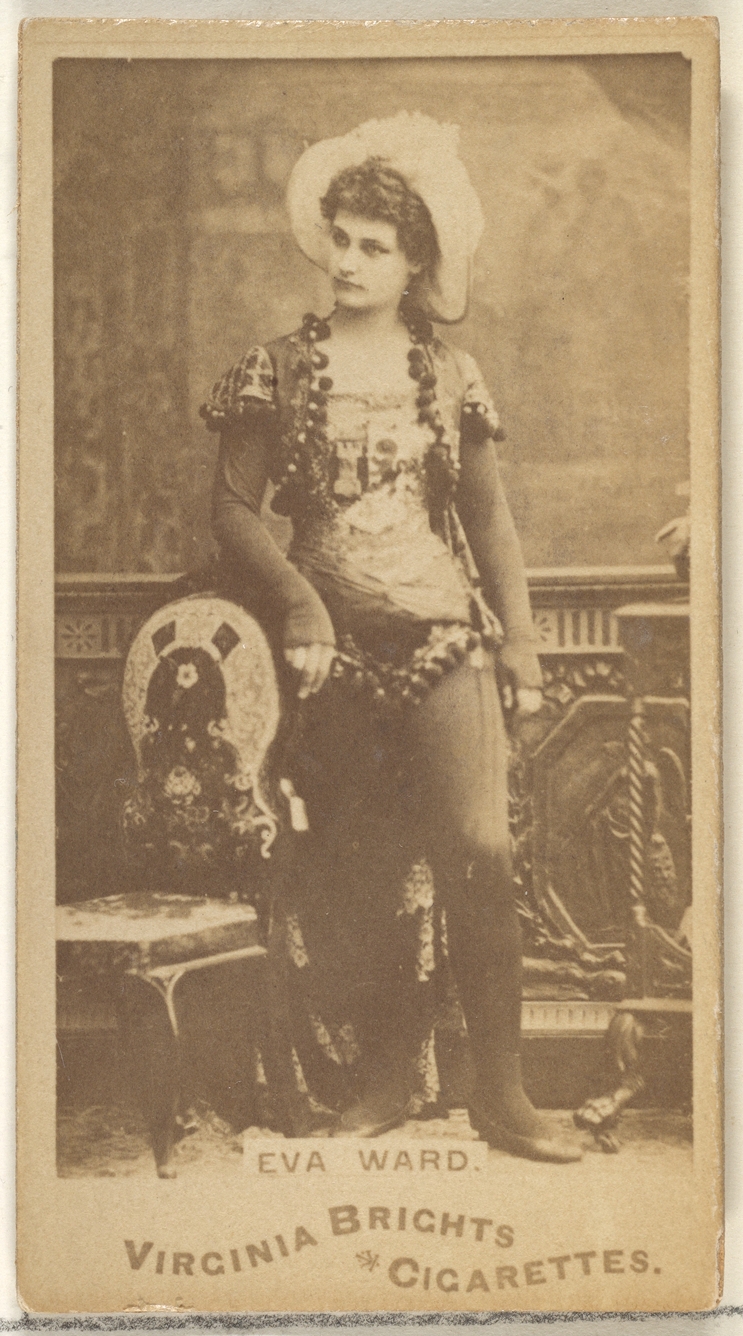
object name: photograph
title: Eva Ward, from the Actors and Actresses series (N45, Type 1) for Virginia Brights Cigarettes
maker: allen & ginter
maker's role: publisher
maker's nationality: american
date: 1888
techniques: albumen silver print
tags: portraits,women,actresses